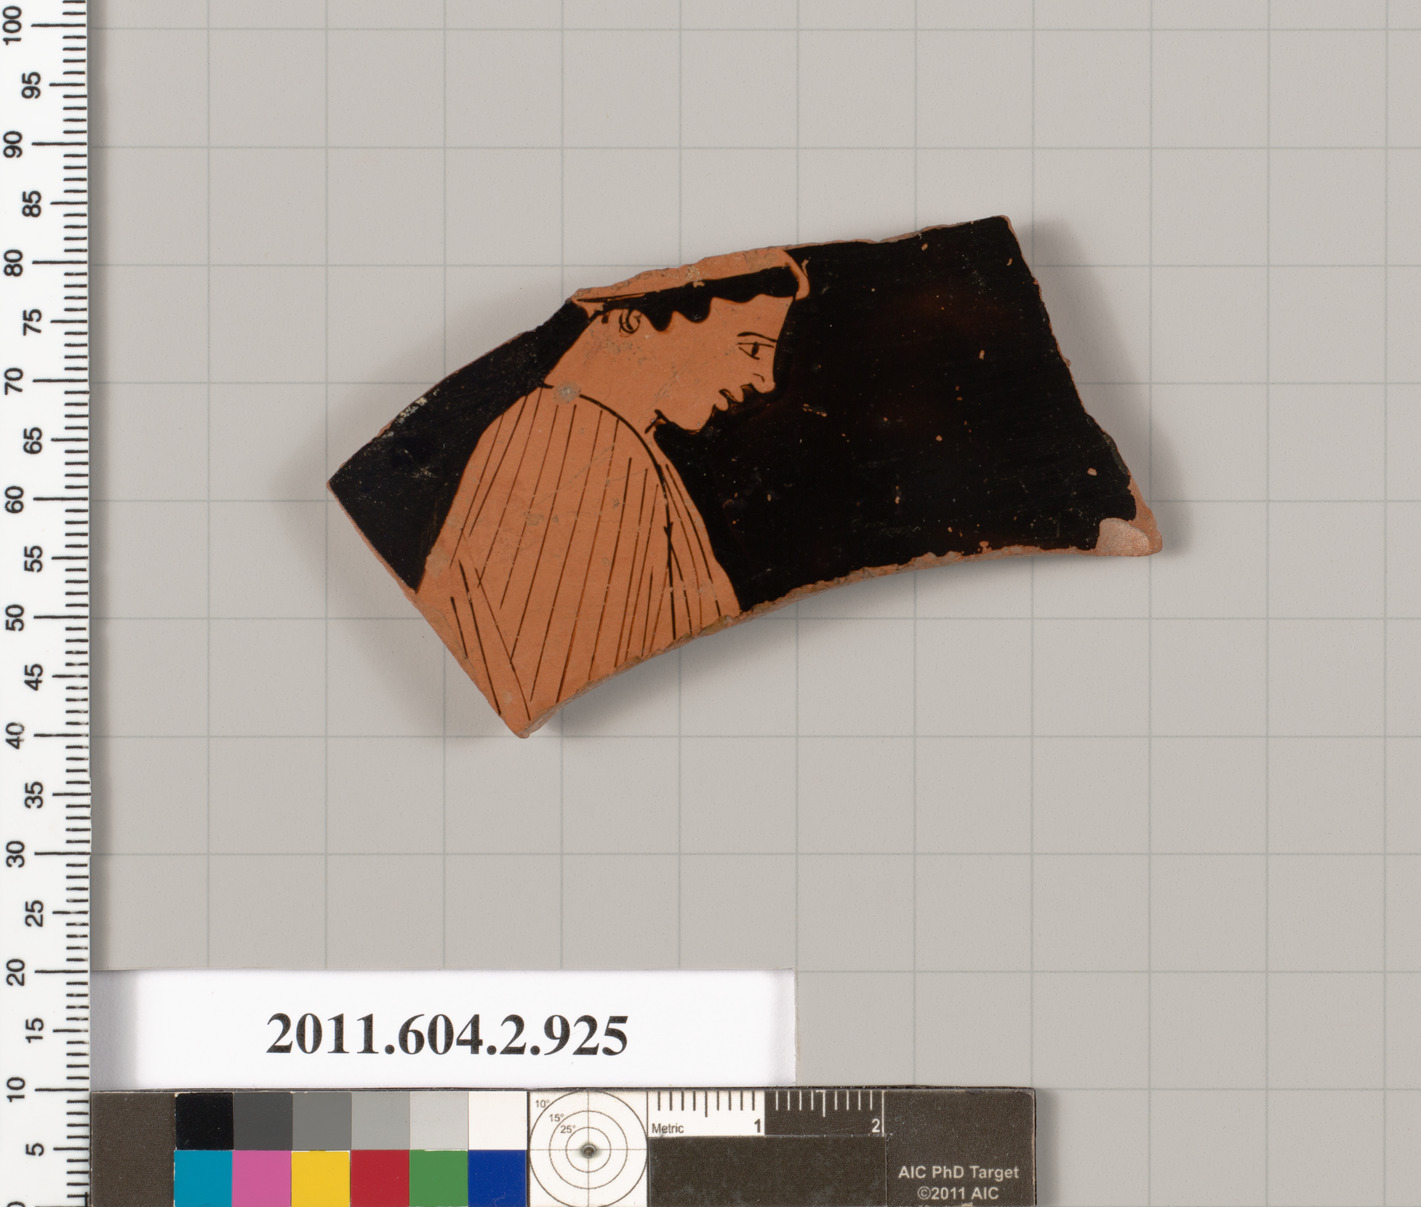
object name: kalpis fragment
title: Terracotta fragment of a hydria: kalpis (water jar)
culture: greek, attic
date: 450-426 BCE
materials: terracotta